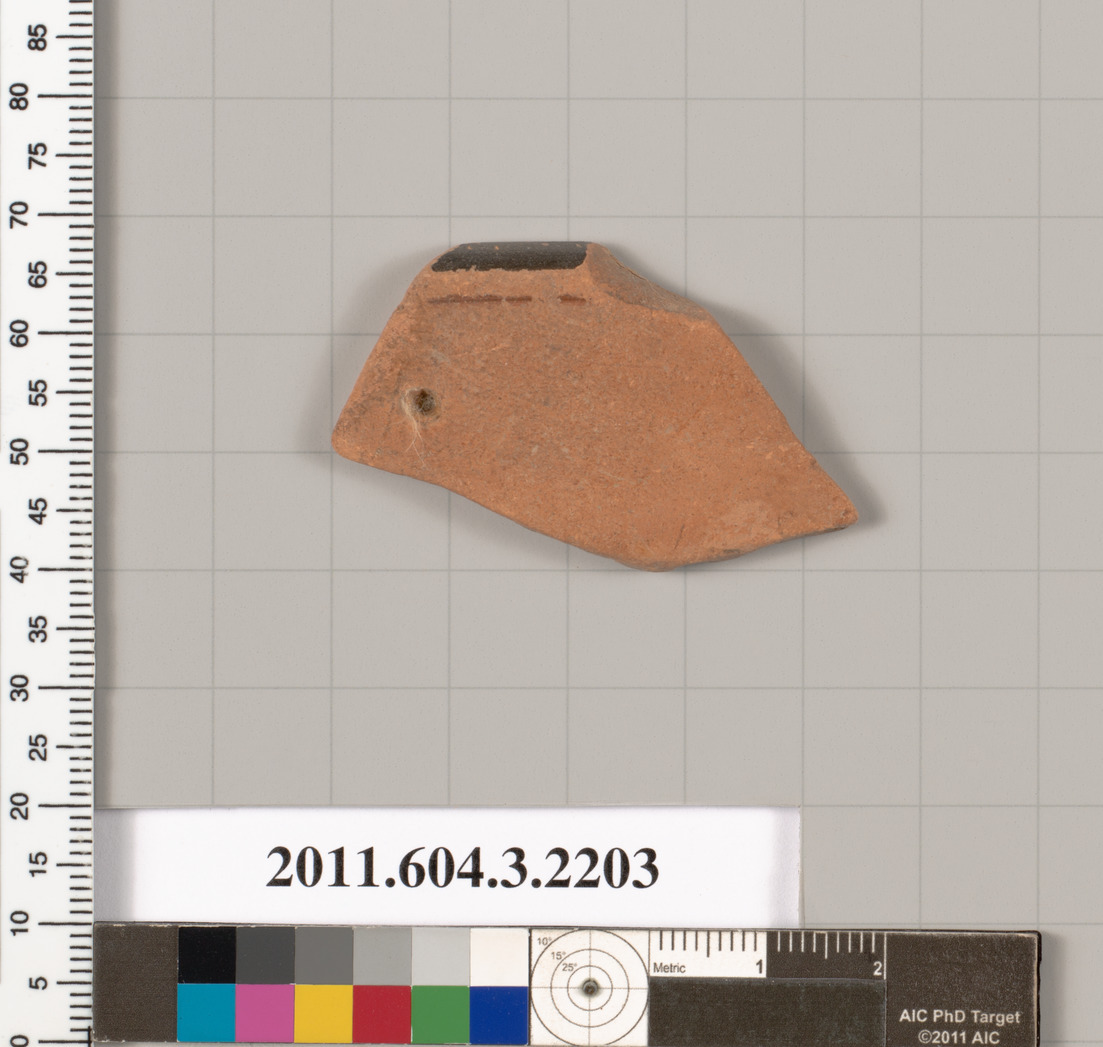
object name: kylix fragment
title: Terracotta rim fragment of a kylix (drinking cup)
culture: greek, attic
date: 600-401 BCE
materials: terracotta